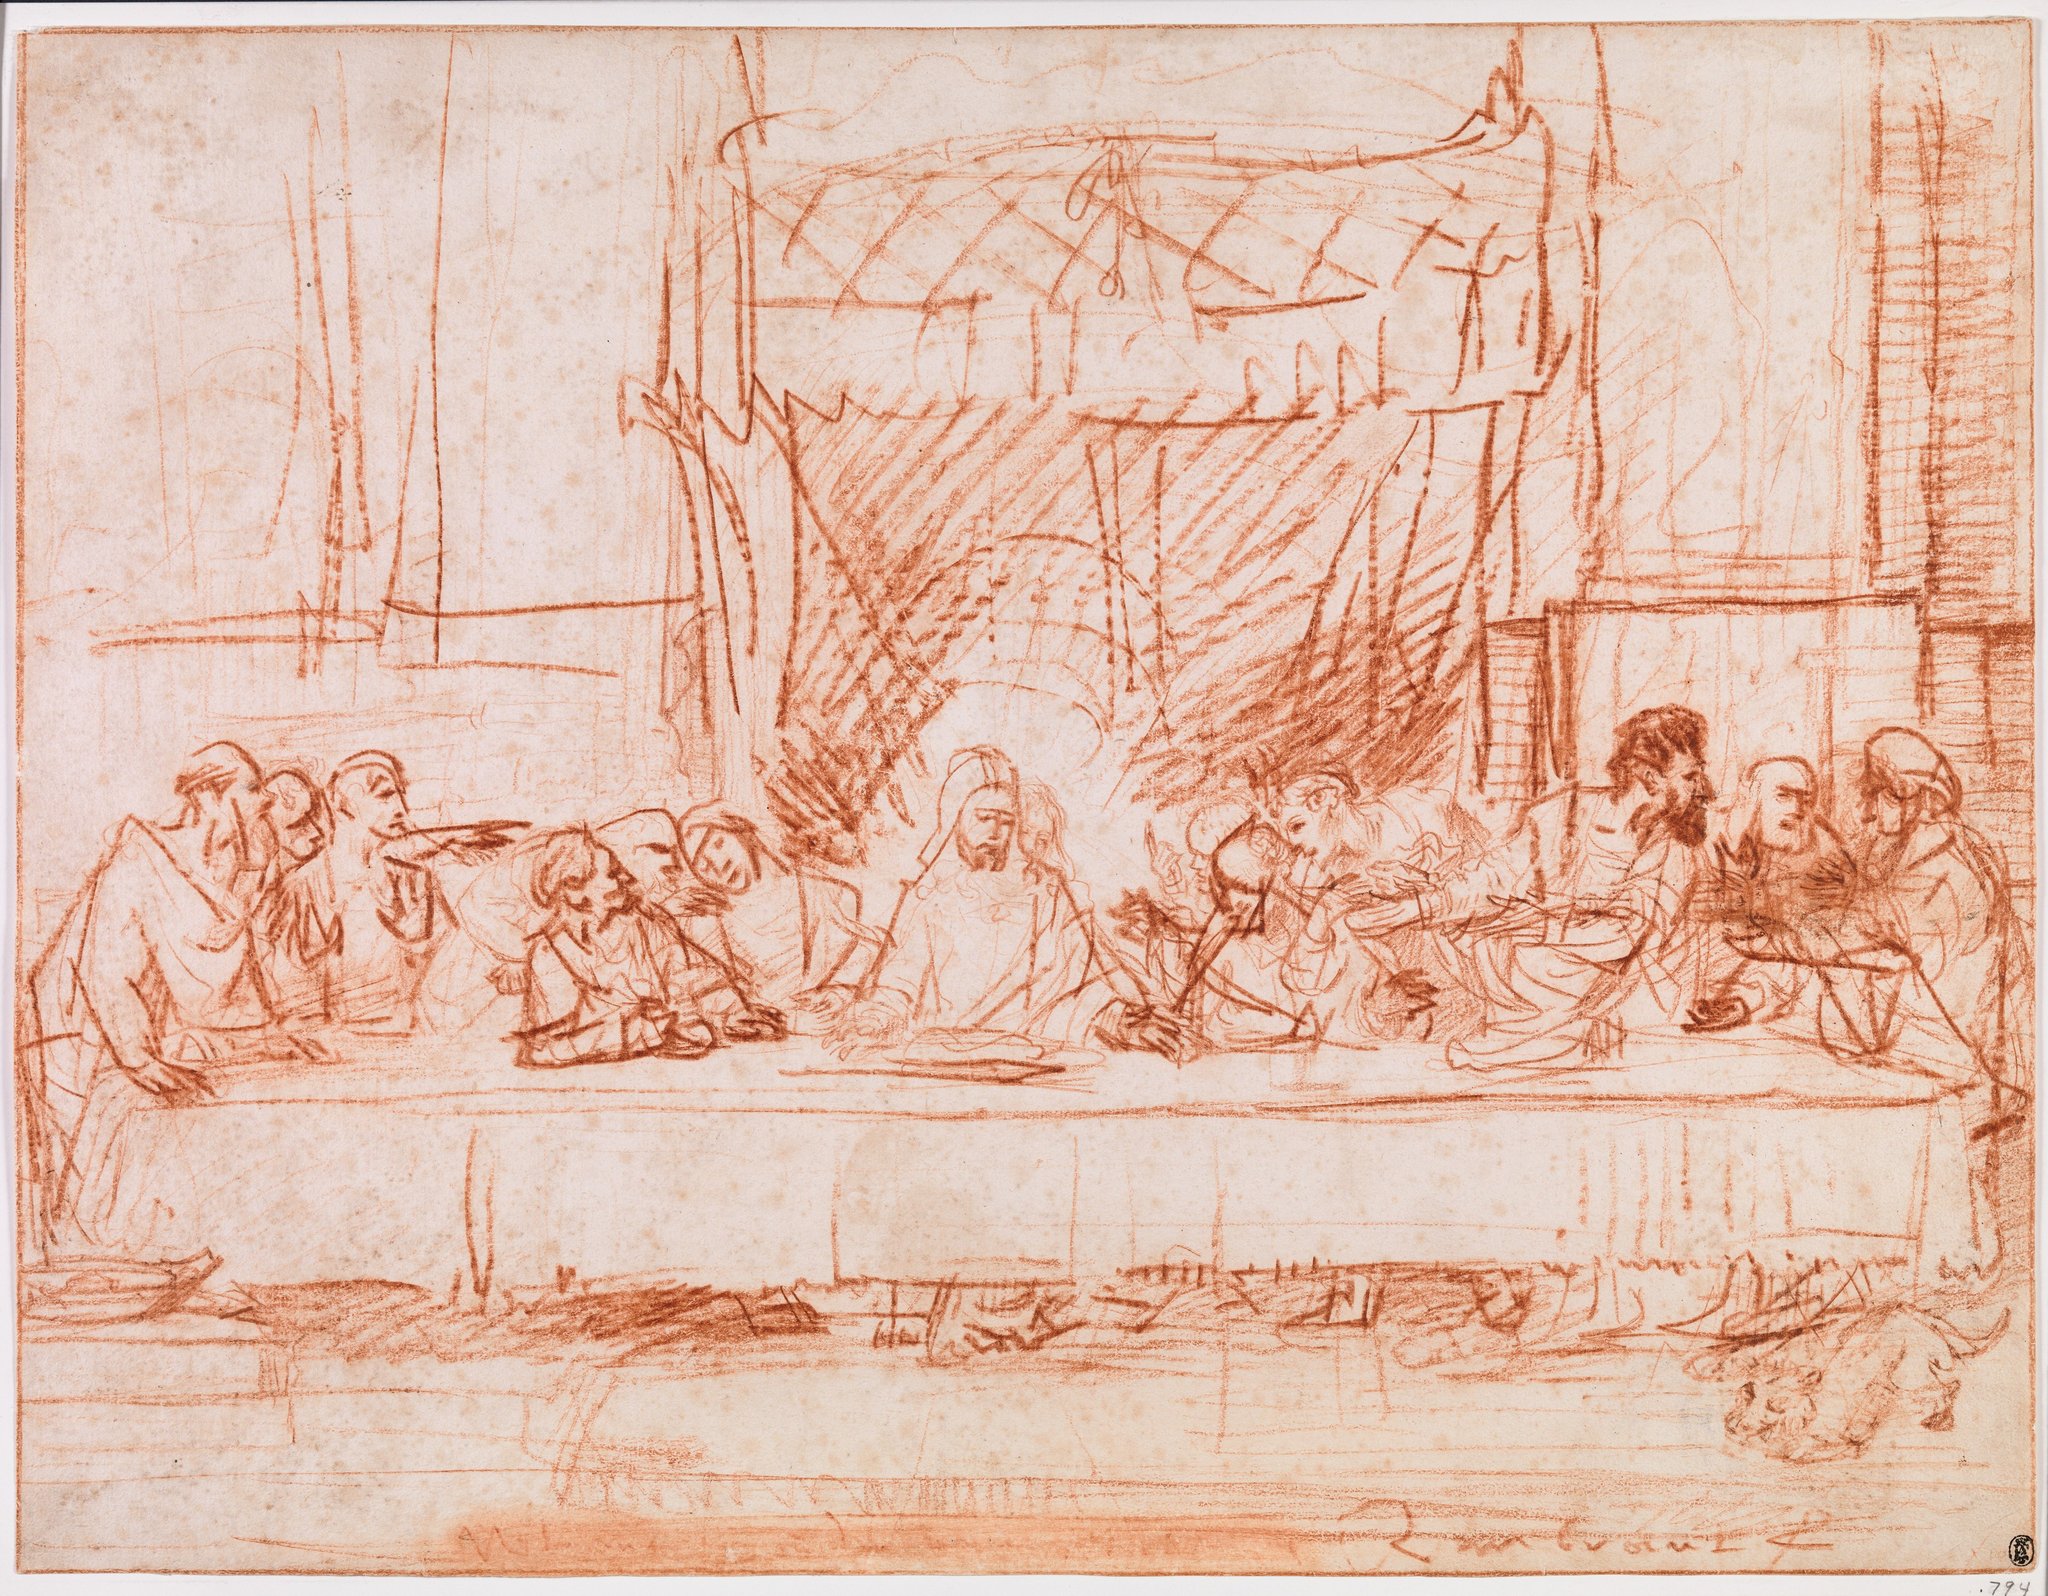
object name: drawing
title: The Last Supper, after Leonardo da Vinci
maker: rembrandt van rijn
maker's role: artist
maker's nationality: dutch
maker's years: 1606-1669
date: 1634-1635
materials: chalk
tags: christ,last supper